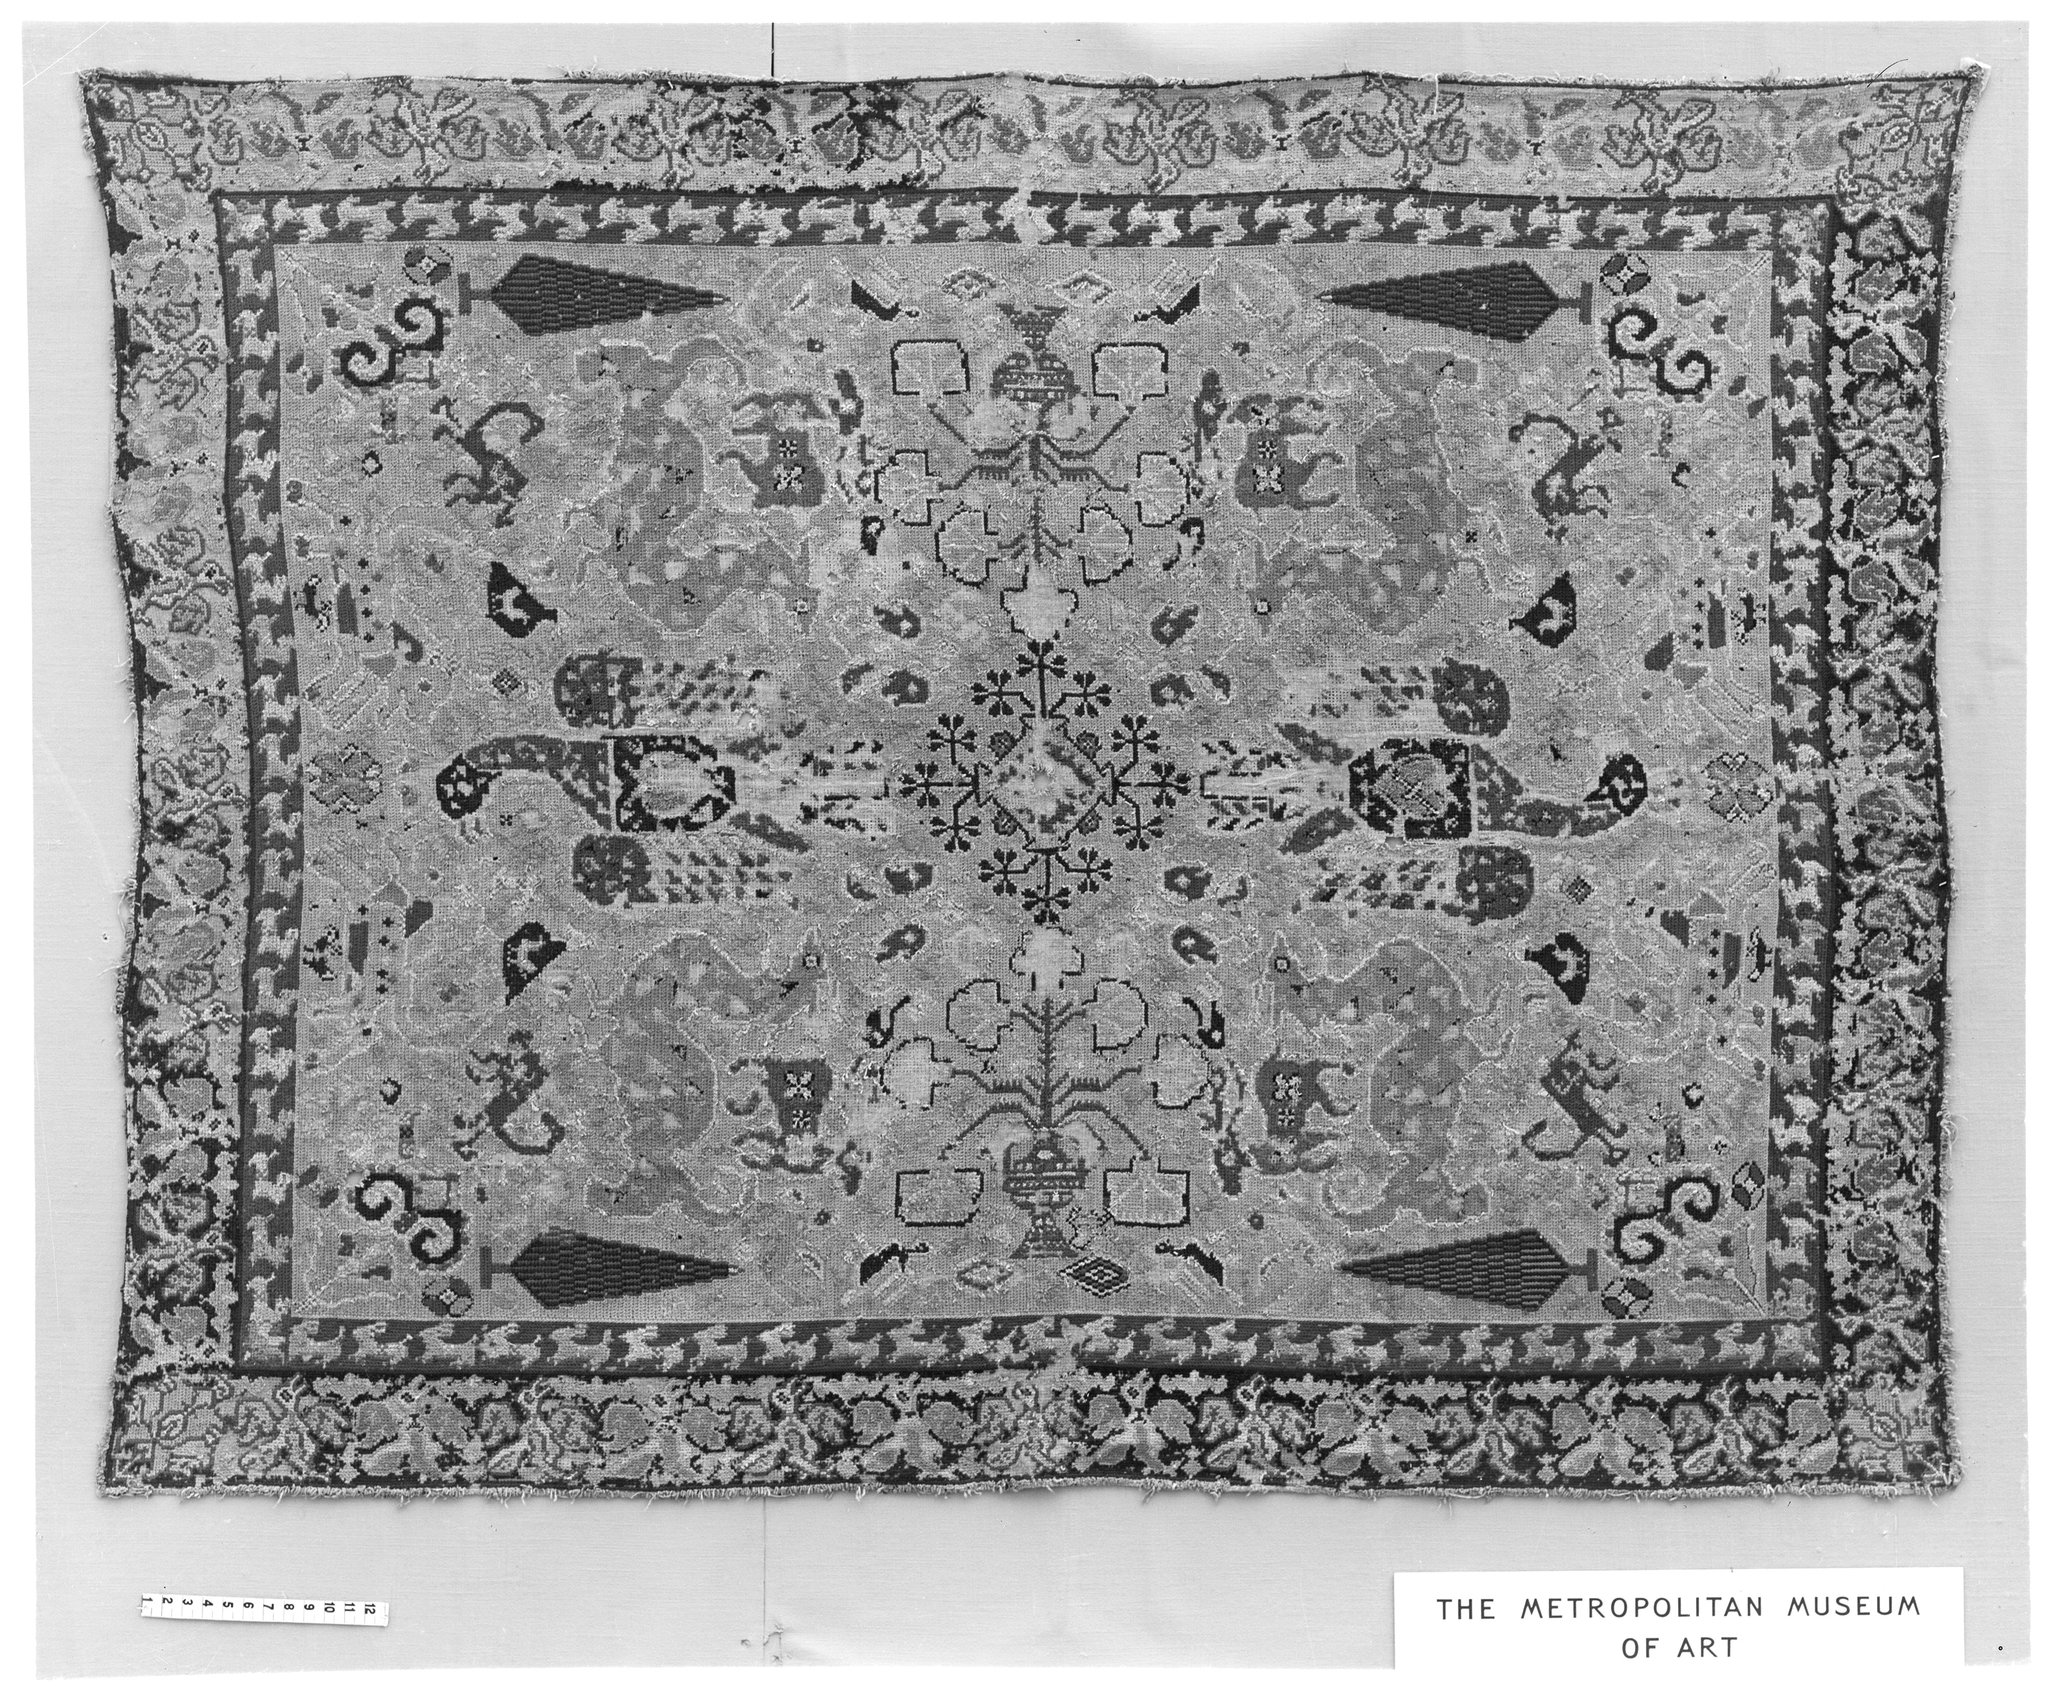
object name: rug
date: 1701-1800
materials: wool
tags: animals,eagles